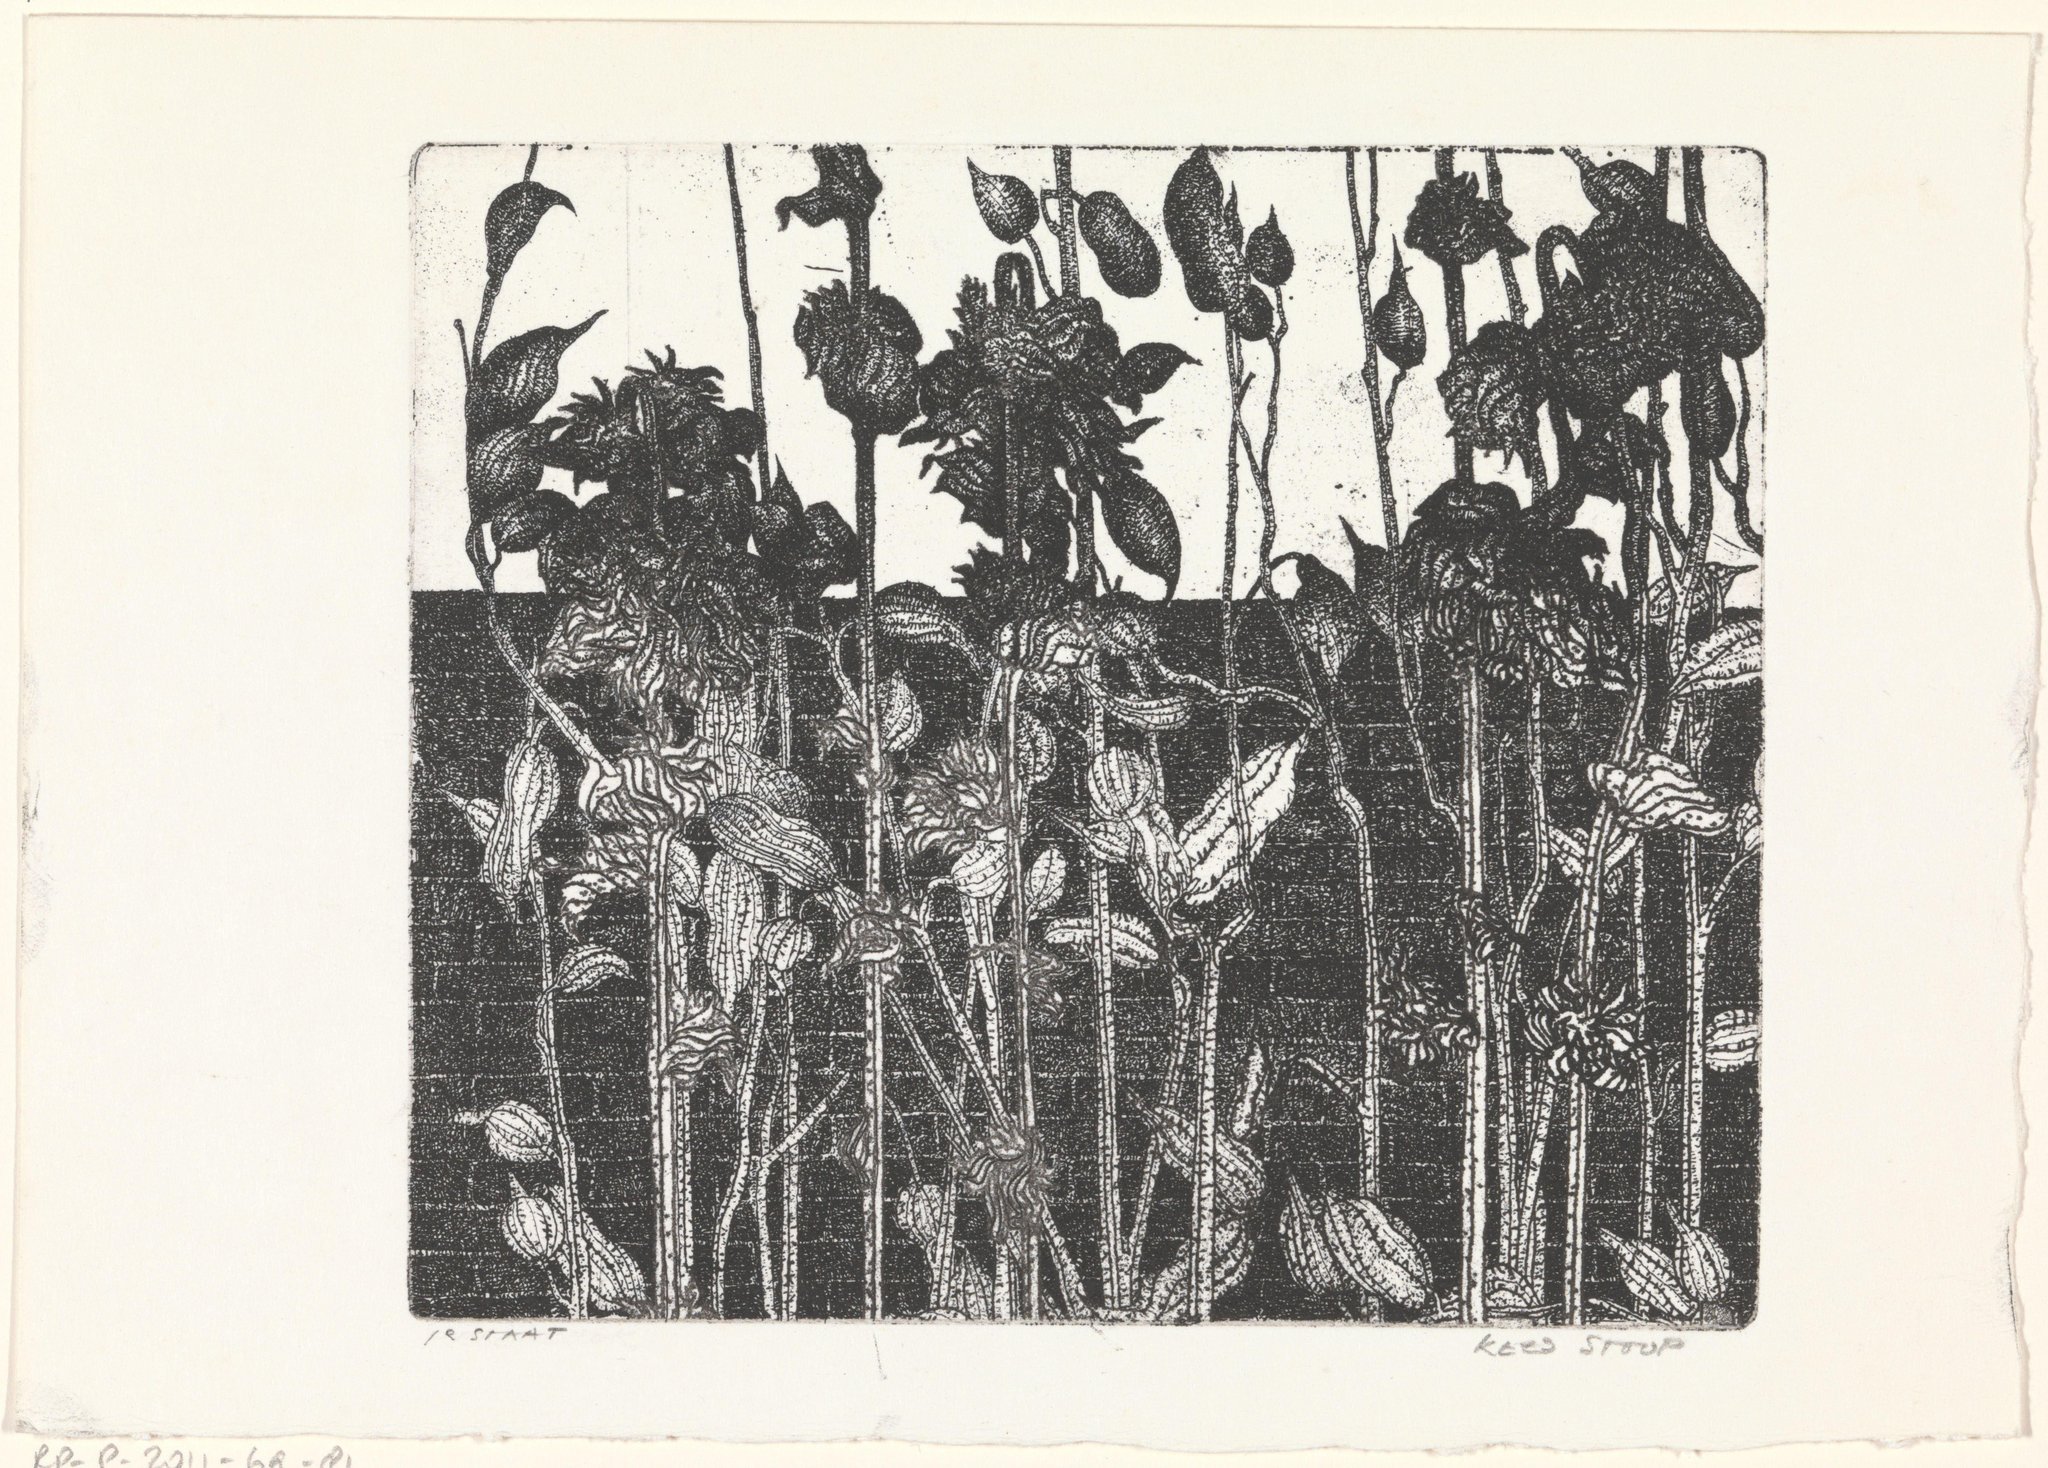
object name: print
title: Begroeiing voor een muur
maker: kees stoop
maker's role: draughtsman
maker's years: 1929-2019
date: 1944-1990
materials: paper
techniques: etching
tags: plants and herbs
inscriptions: signature: ‘KEES STOOP’, inscription: ‘1e STAAT’